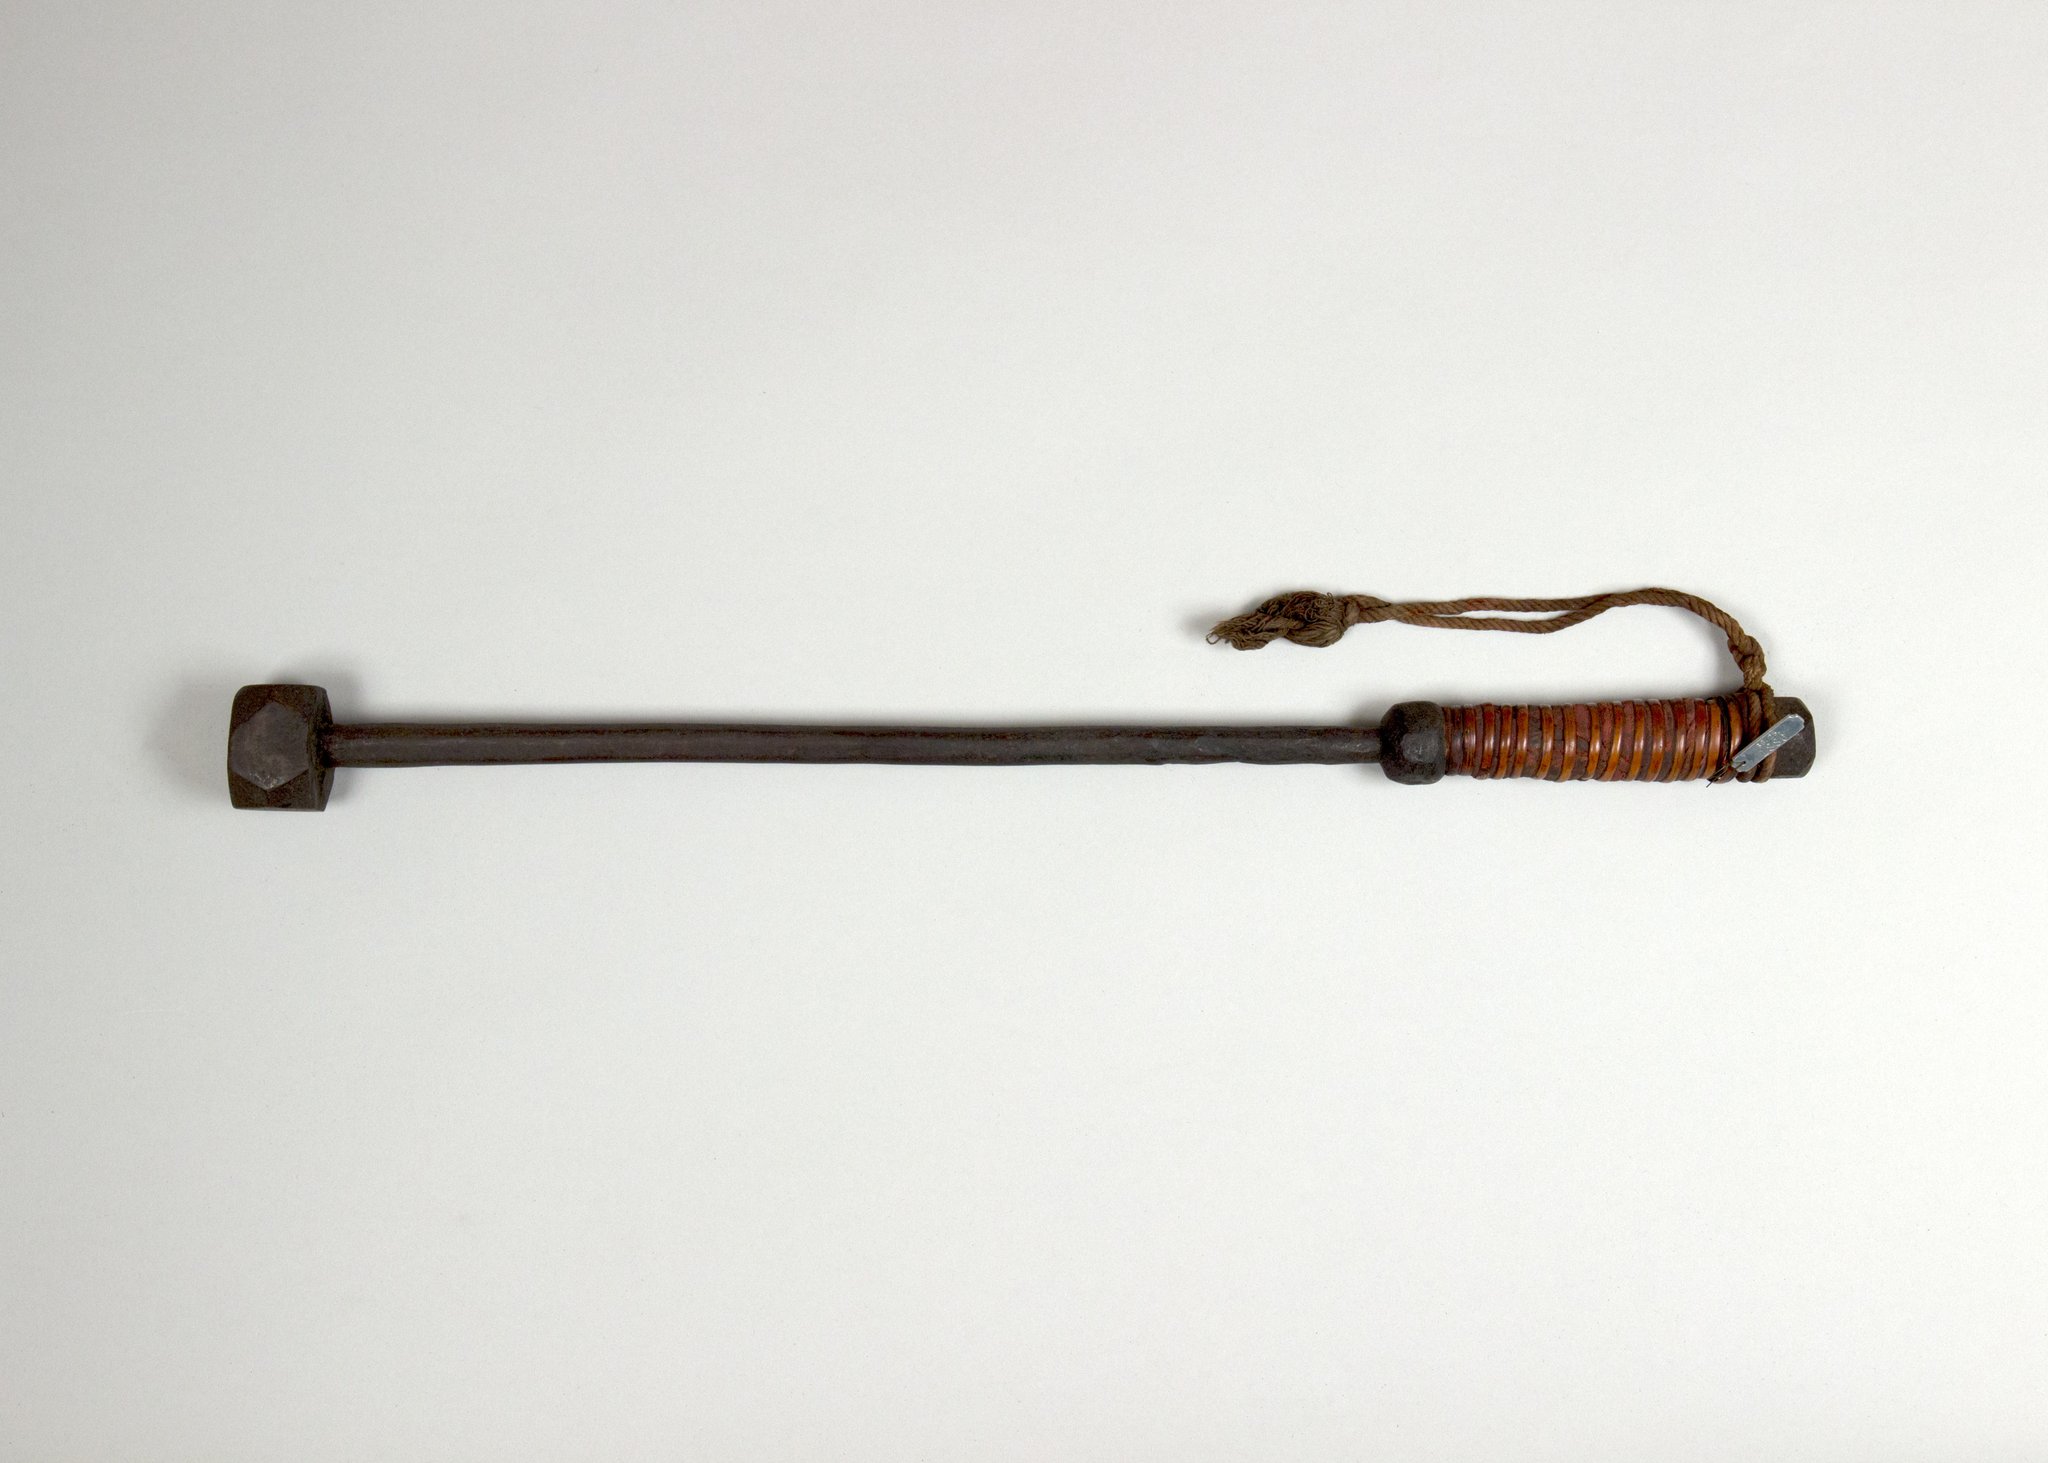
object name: mace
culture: chinese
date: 1701-1900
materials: iron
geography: china